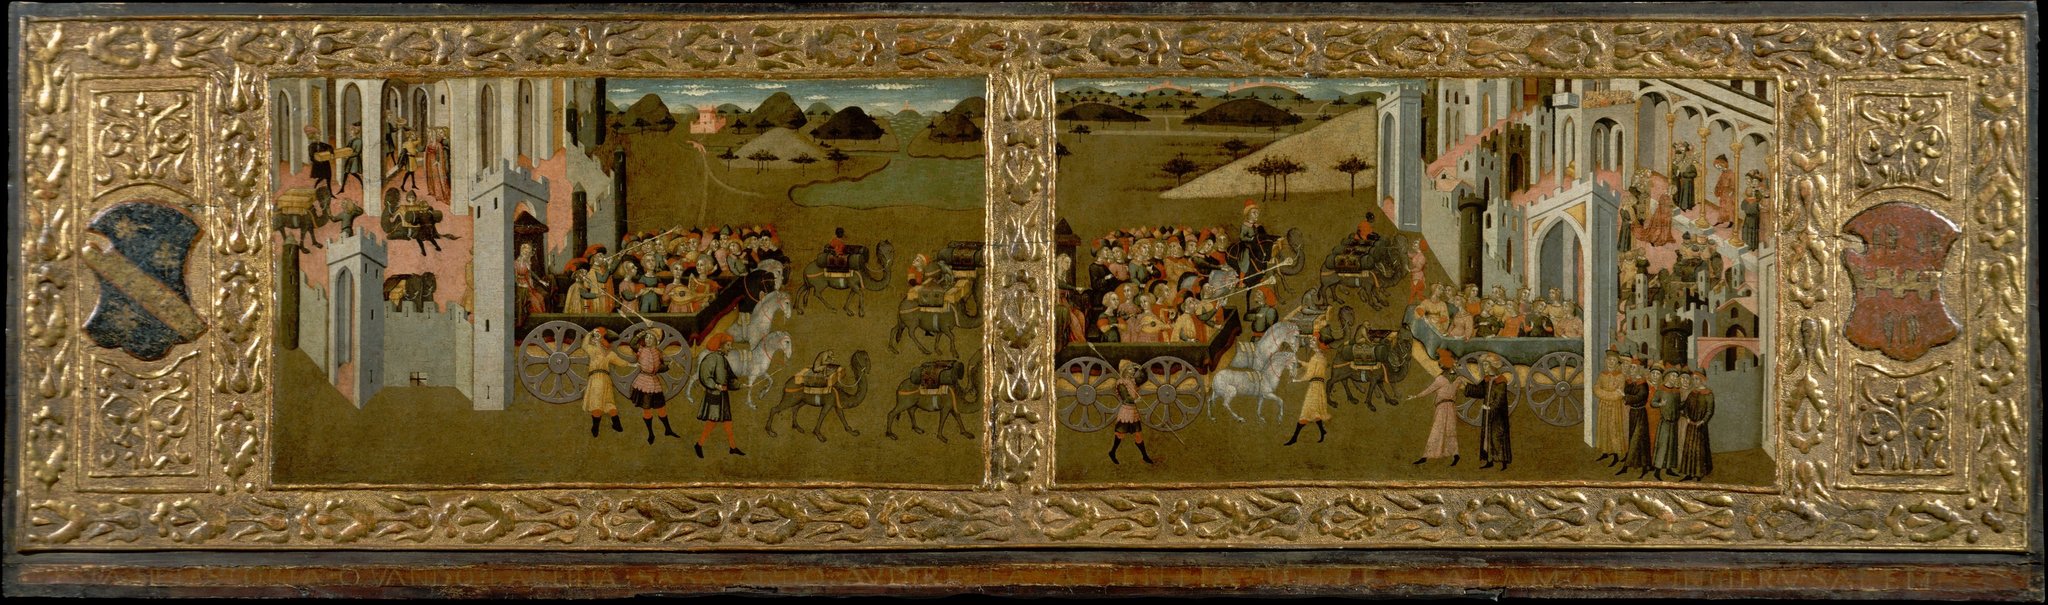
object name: painting, cassone panel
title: King Solomon and the Queen of Sheba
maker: master of lecceto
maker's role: artist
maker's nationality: italian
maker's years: 1450-1474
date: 1450-1474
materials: gilt, paint, wood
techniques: embossing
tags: camels,horses,crowd,carts,wagons